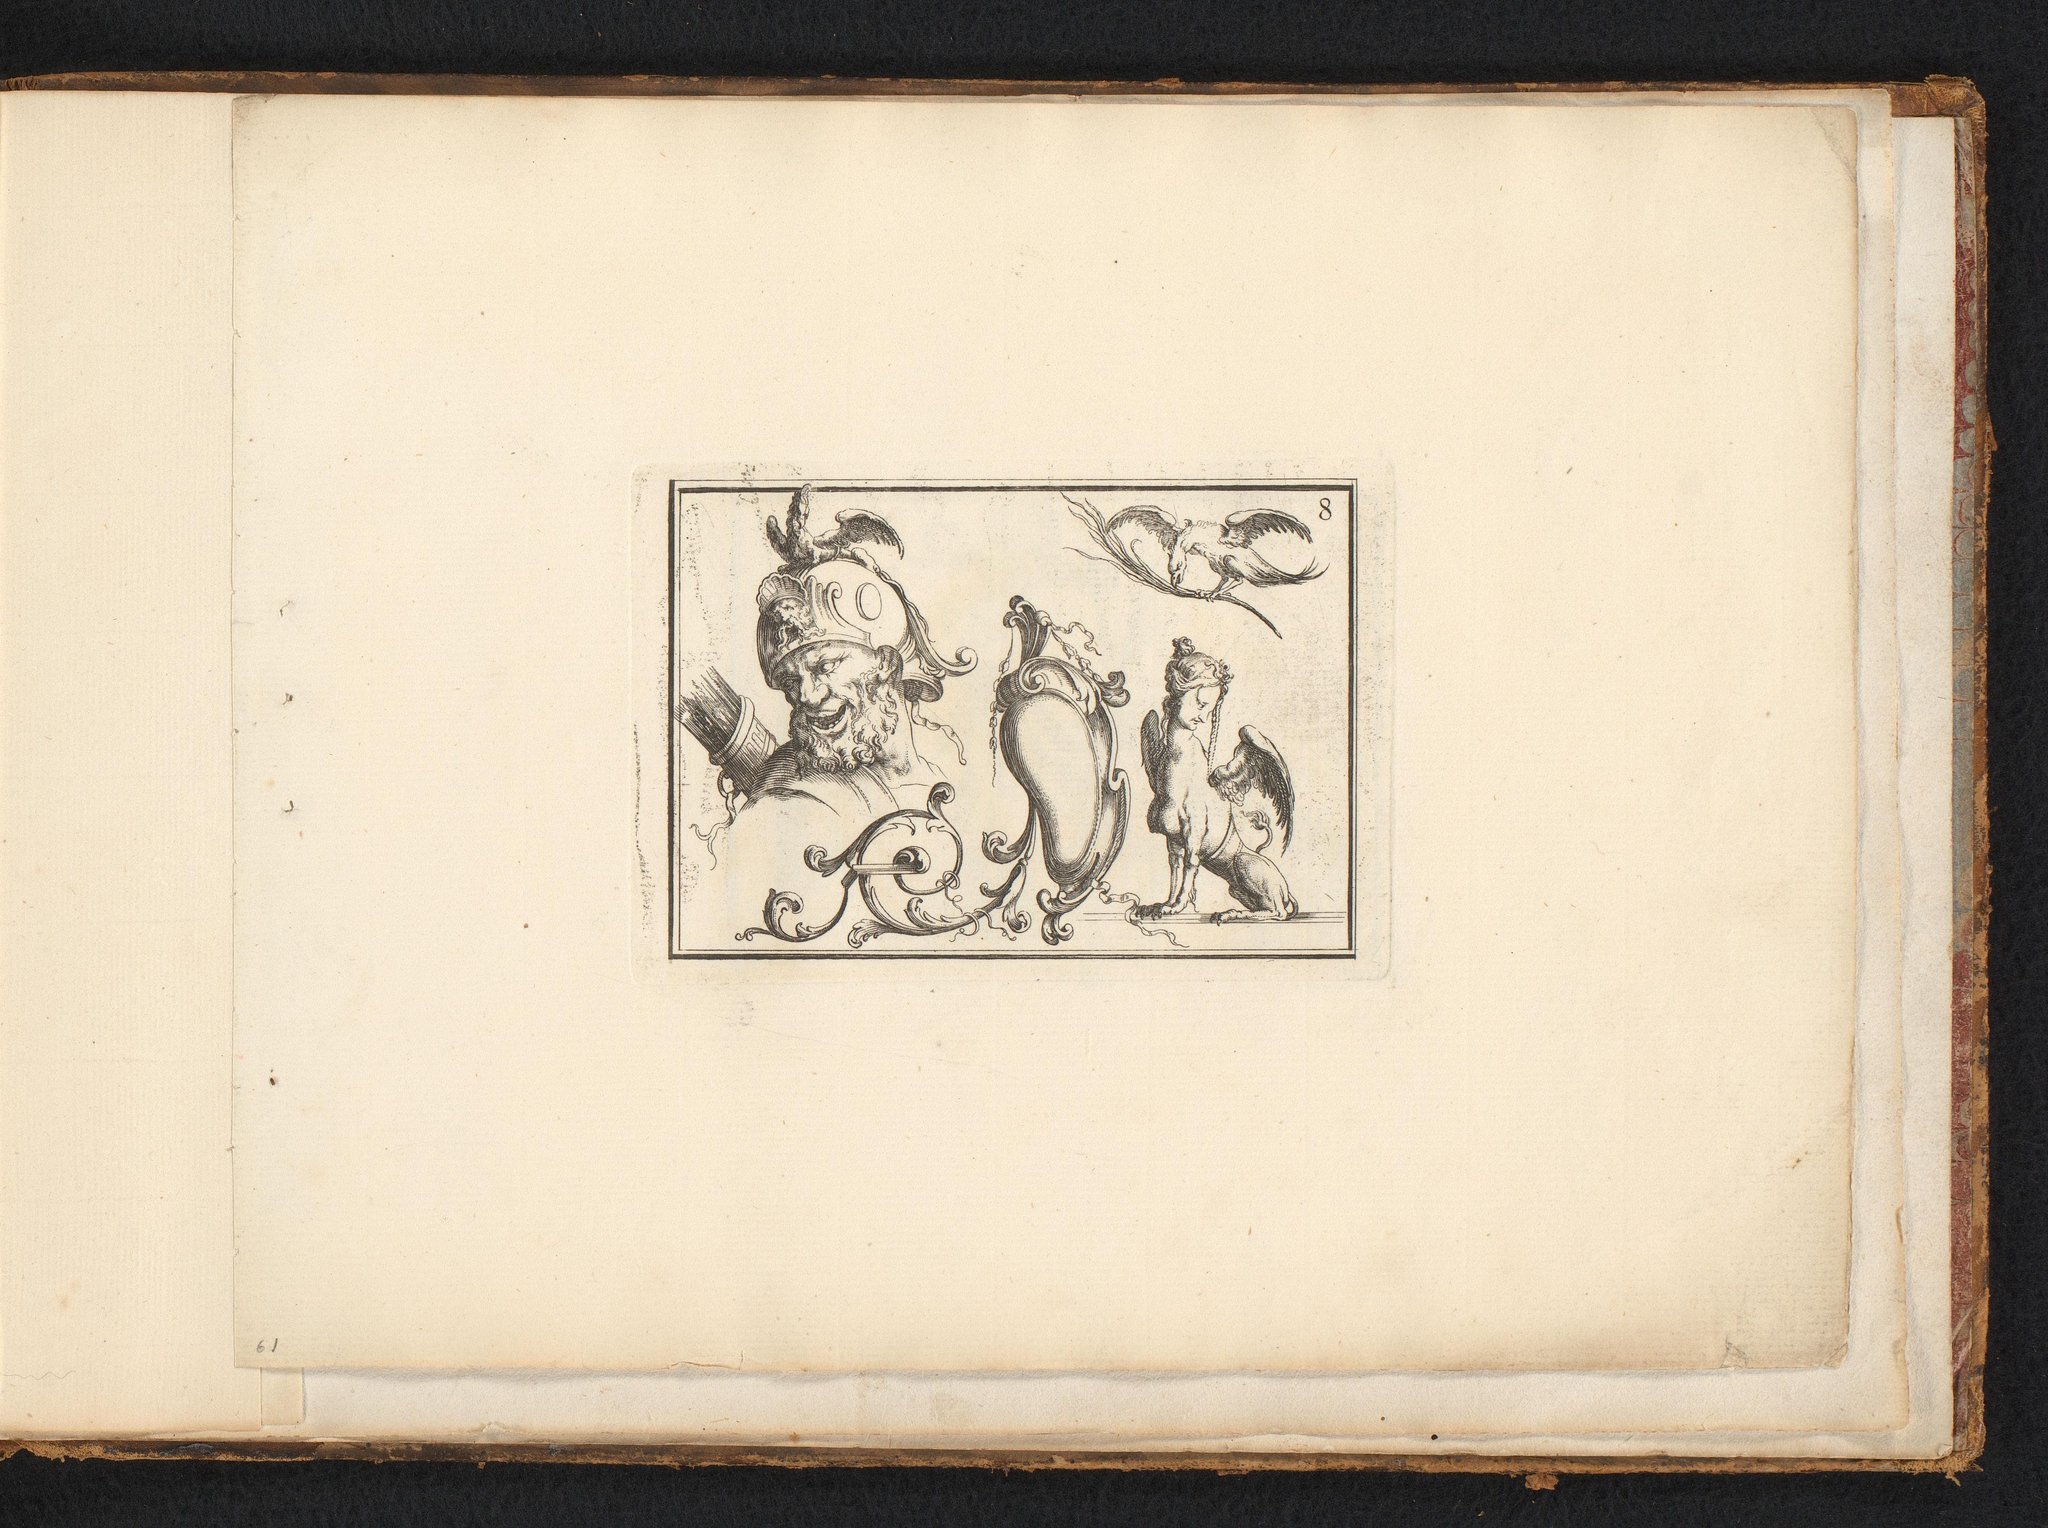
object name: print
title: Cartouche met sfinx en soldaat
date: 1745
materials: paper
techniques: etching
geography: london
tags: fabulous animals (sometimes wrongly called 'grotesques'); 'mostri' (ripa), ornament ~ cartouche, mask, mascaron ~ ornament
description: Rechtsboven genummerd: 8. Prent maakt deel uit van een album.